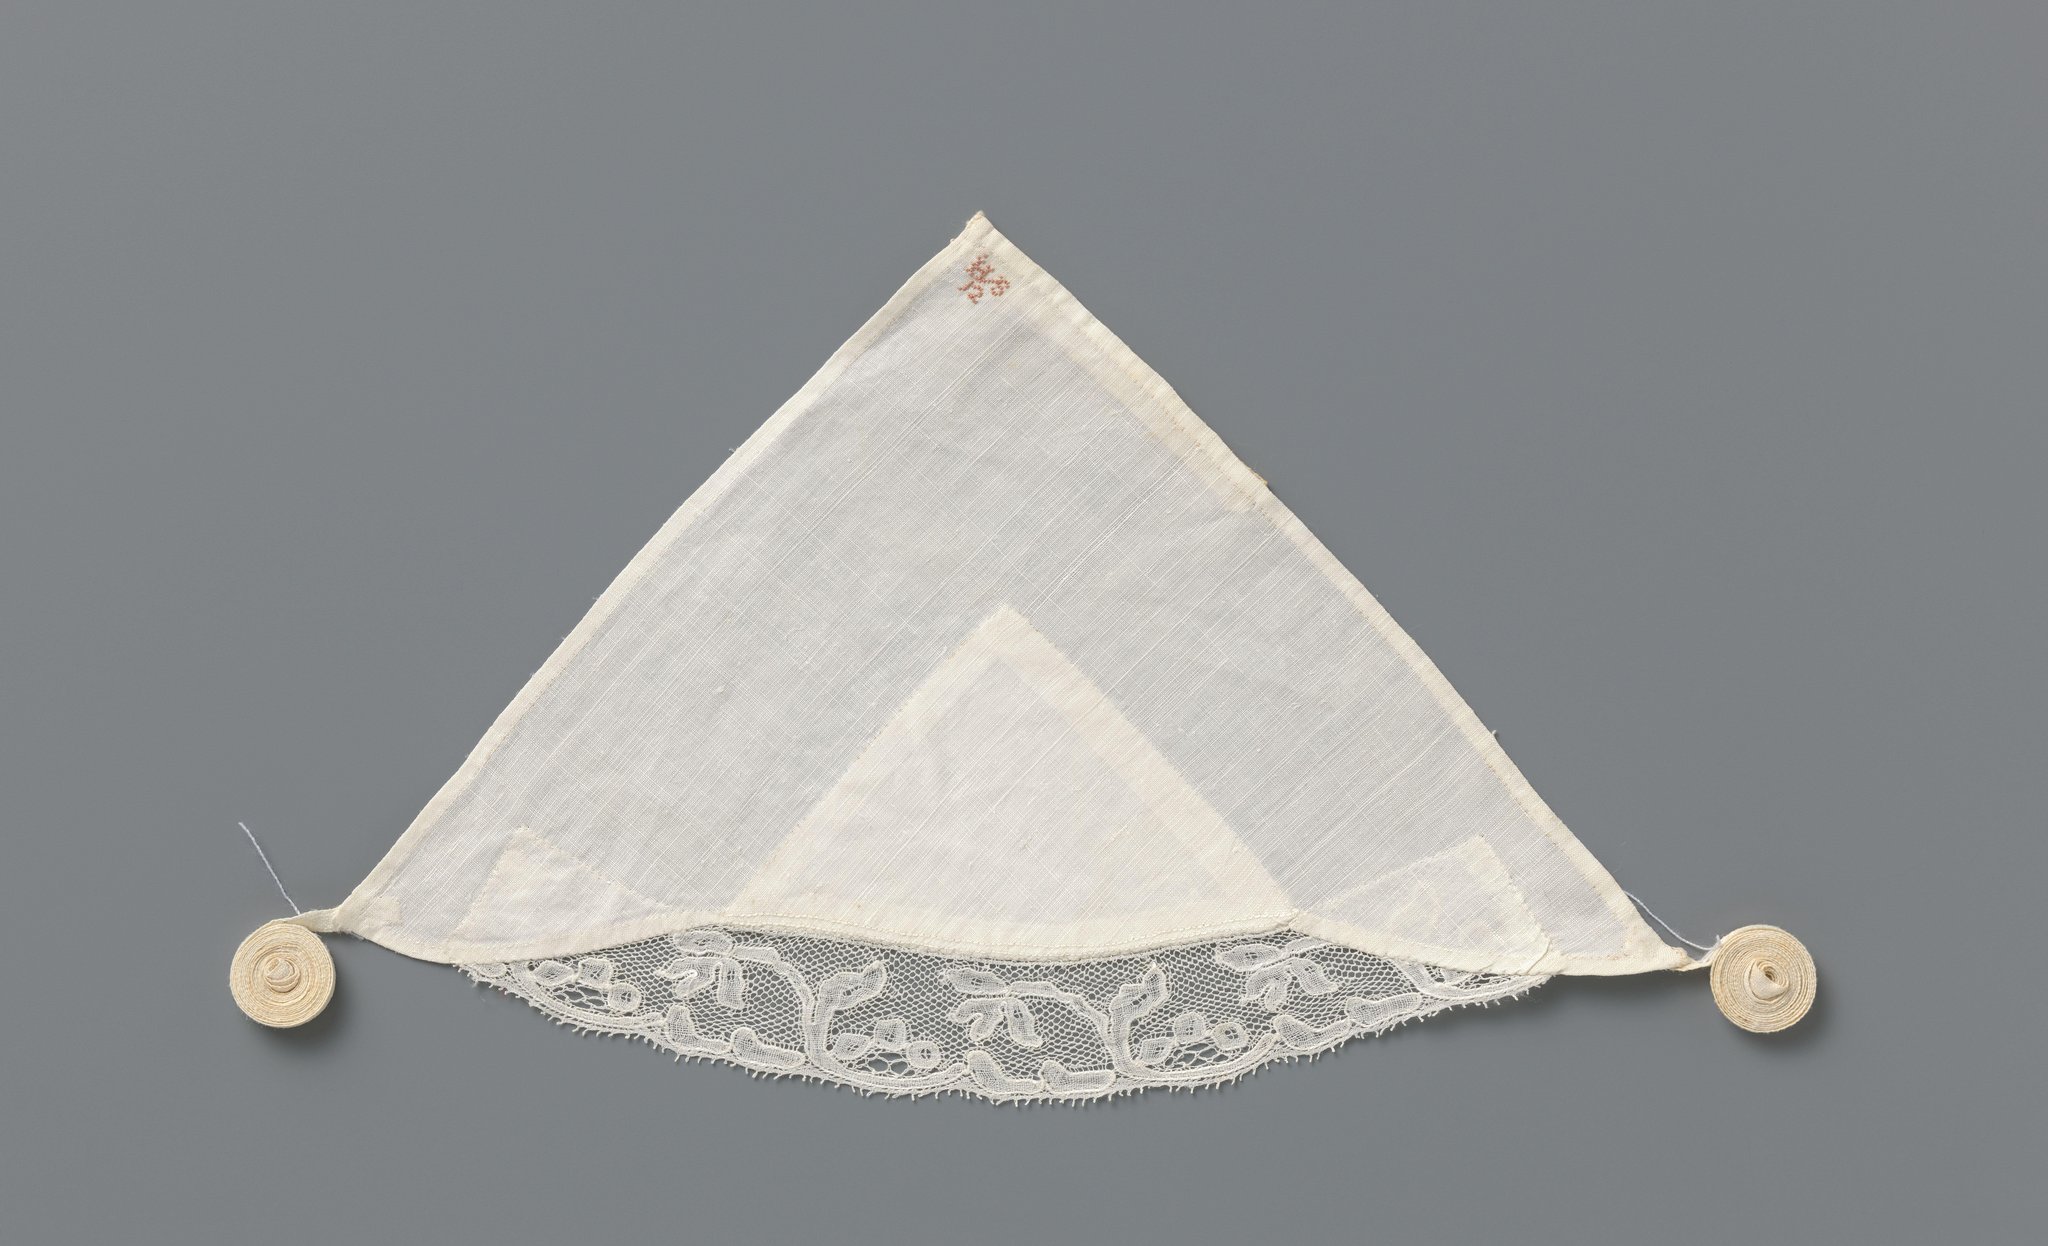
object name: childrenswear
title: Fontaneldoek van wit linnen met kant; in rode kruissteek gemerkt: HS12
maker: Anonymous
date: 1750-1900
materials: linen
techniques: cross stitching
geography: europe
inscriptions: inscription: ‘HS / 12’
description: 12 linnen fontanelletjes met verschillende kant afgezet , 4 gemerkt LH8, 3 gem. H8, 5 gem. HVS(Gr. Hoogenhuize "1772-1852" tr. 1802 S.E. von schmid "1771-1843"). 1 van damast gem. HH6 (W.r. Hoogenhuize "1747-1804" tr 1787 W. Helmerich "1752").